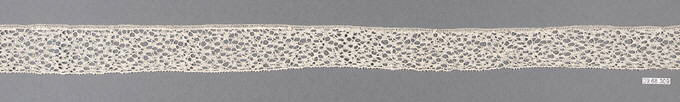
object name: strip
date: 1601-1700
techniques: lace